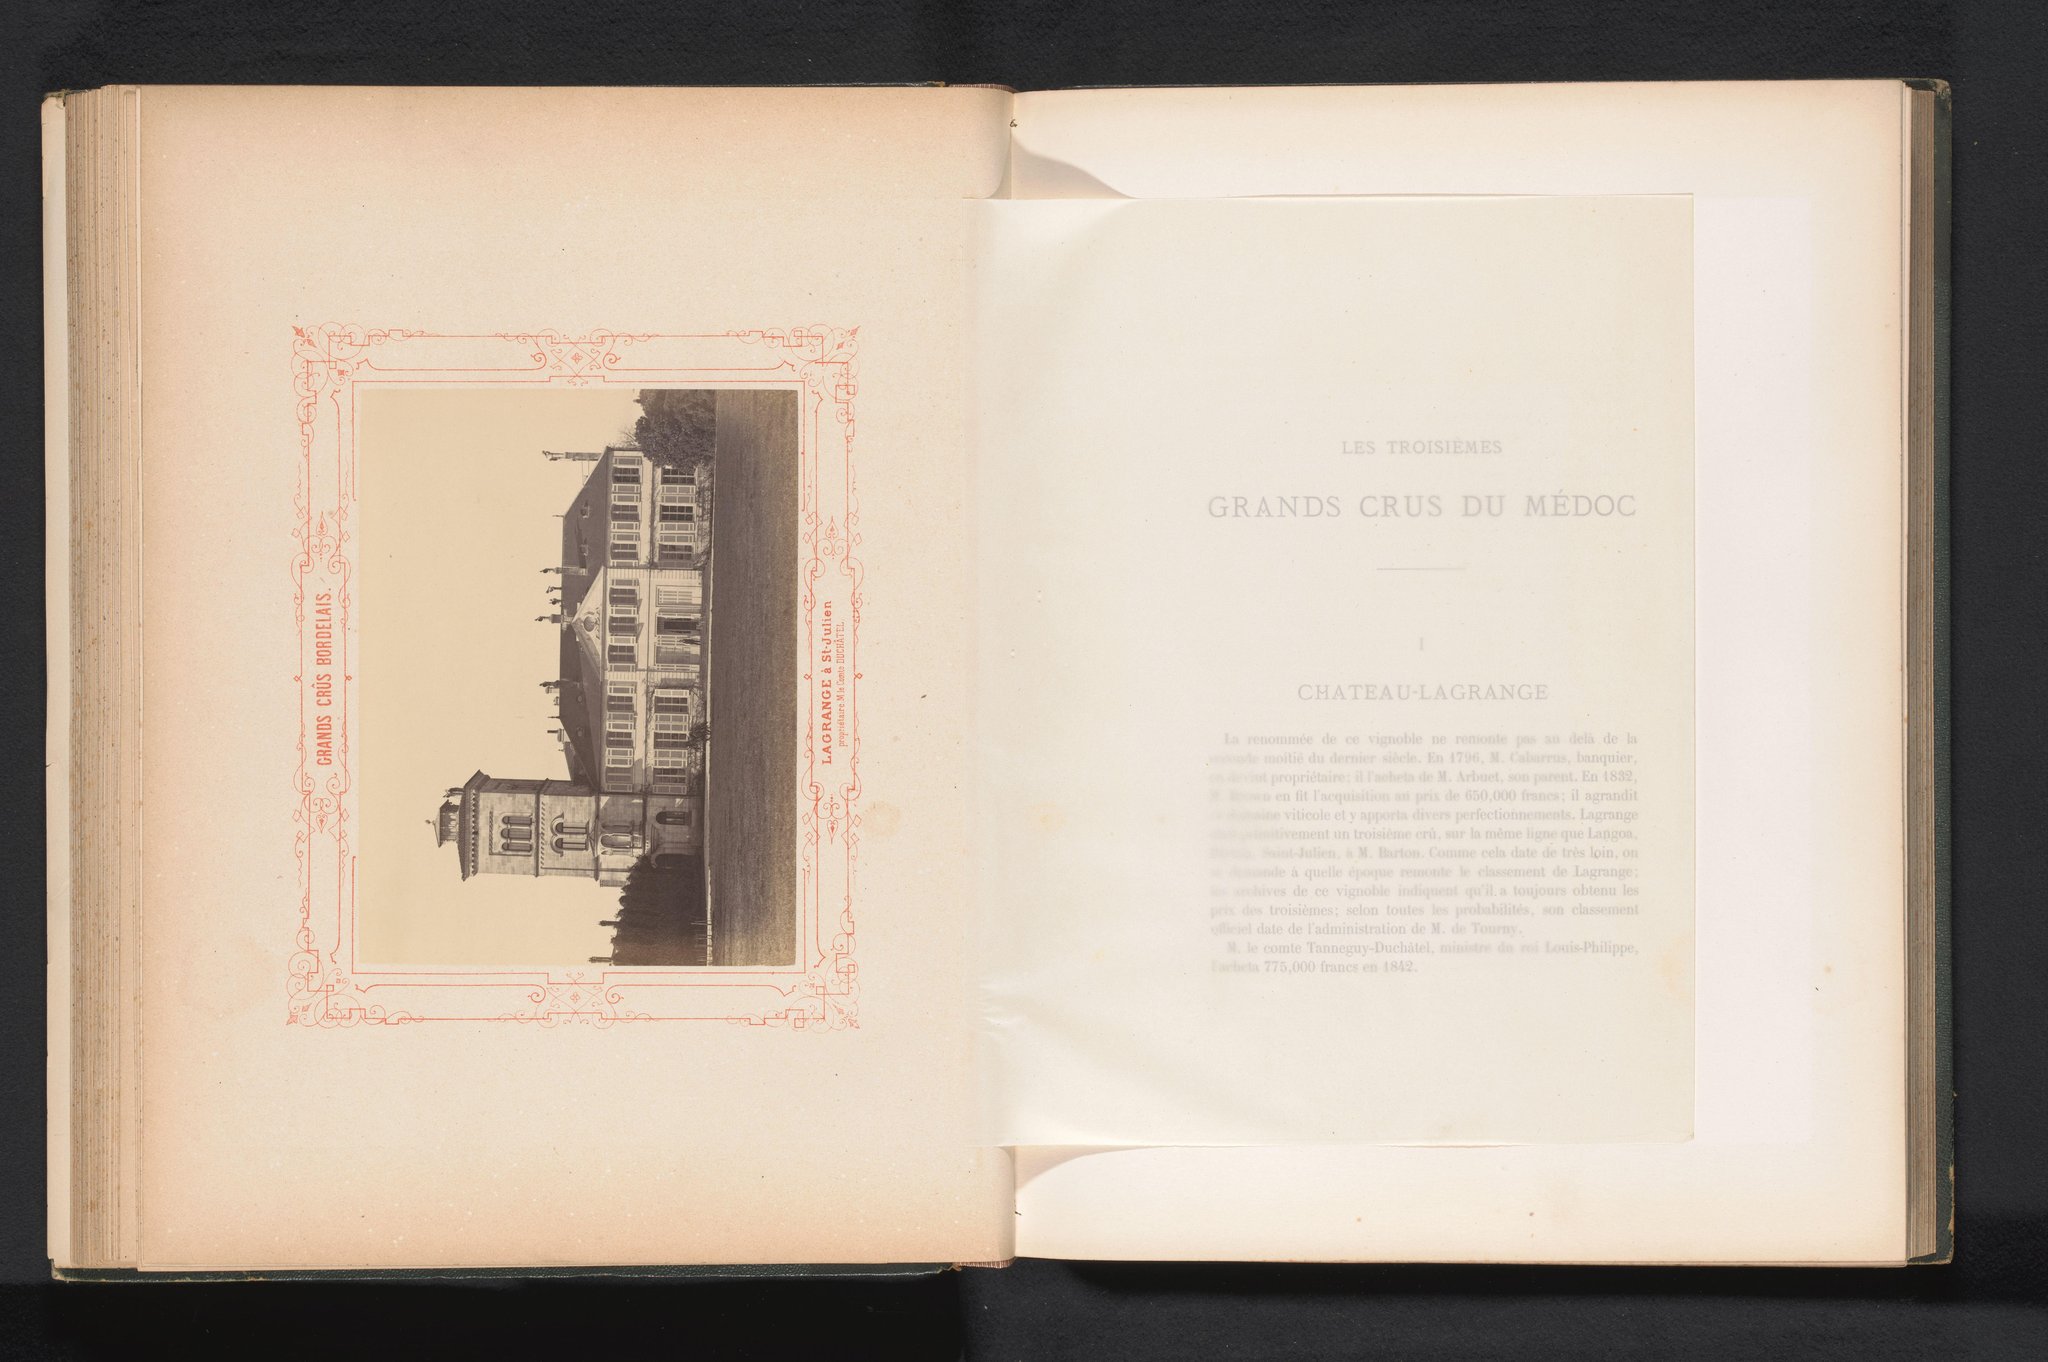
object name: photograph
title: La Gironde à Vol d'Oiseau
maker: alfred danflou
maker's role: fotograaf, schrijver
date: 1862-1867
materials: photographic support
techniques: albumen print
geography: saint-julien-beychevelle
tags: castle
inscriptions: inscription: ‘propriétaire: M. le Come DUCHÂTEL.’